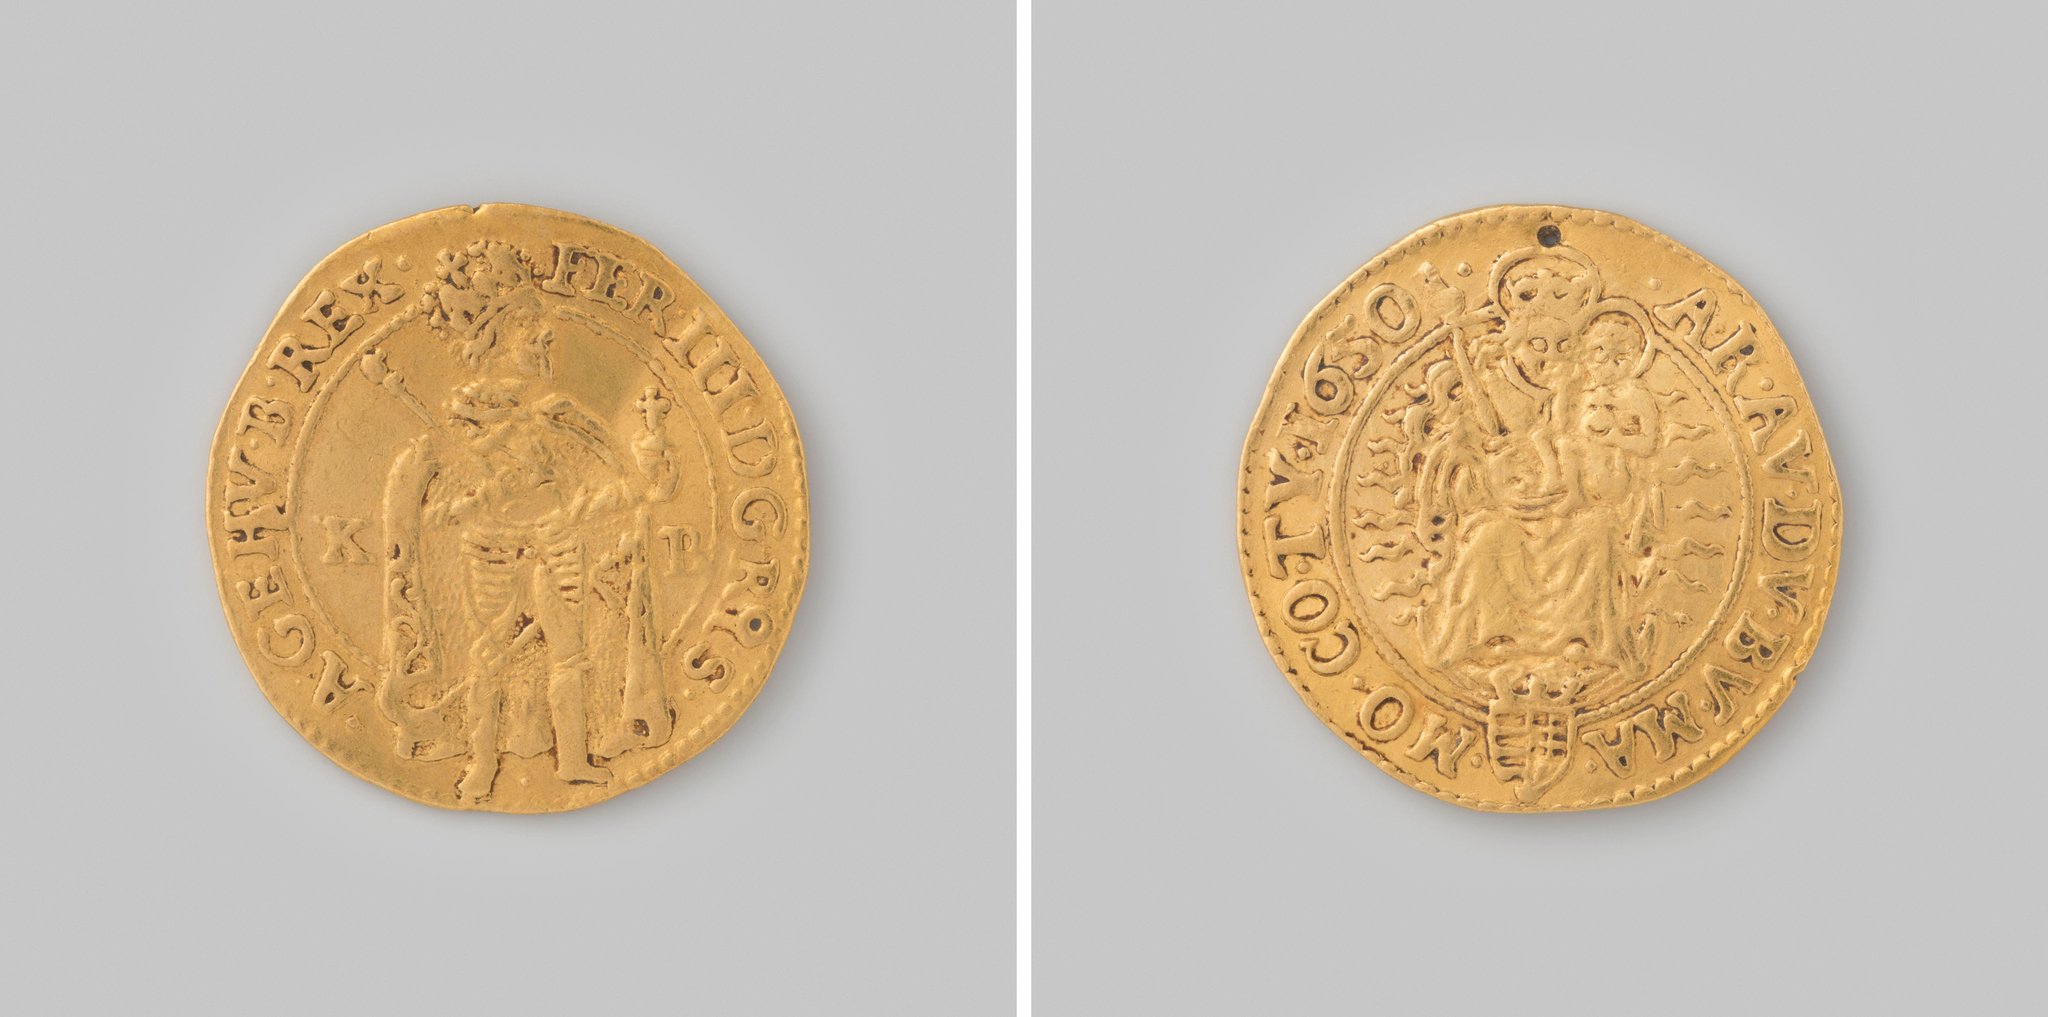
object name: coin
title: Hongarije, Ferdinand III, dukaat,1650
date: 1650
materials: gold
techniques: striking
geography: kremnica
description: Gouden munt. Voorzijde: tussen letters K en B [=Kremnitz] de gekroonde vorst, staande, met in zijn linkerhand een rijksappel en in zijn rechterhand een scepter. Keerzijde: binnen een stralenkrans de madonna met het kind, waaronder een wapenschild. Jaartal aan het eind van het omschrift. Klein, later aangebracht gat in muntplaatje.